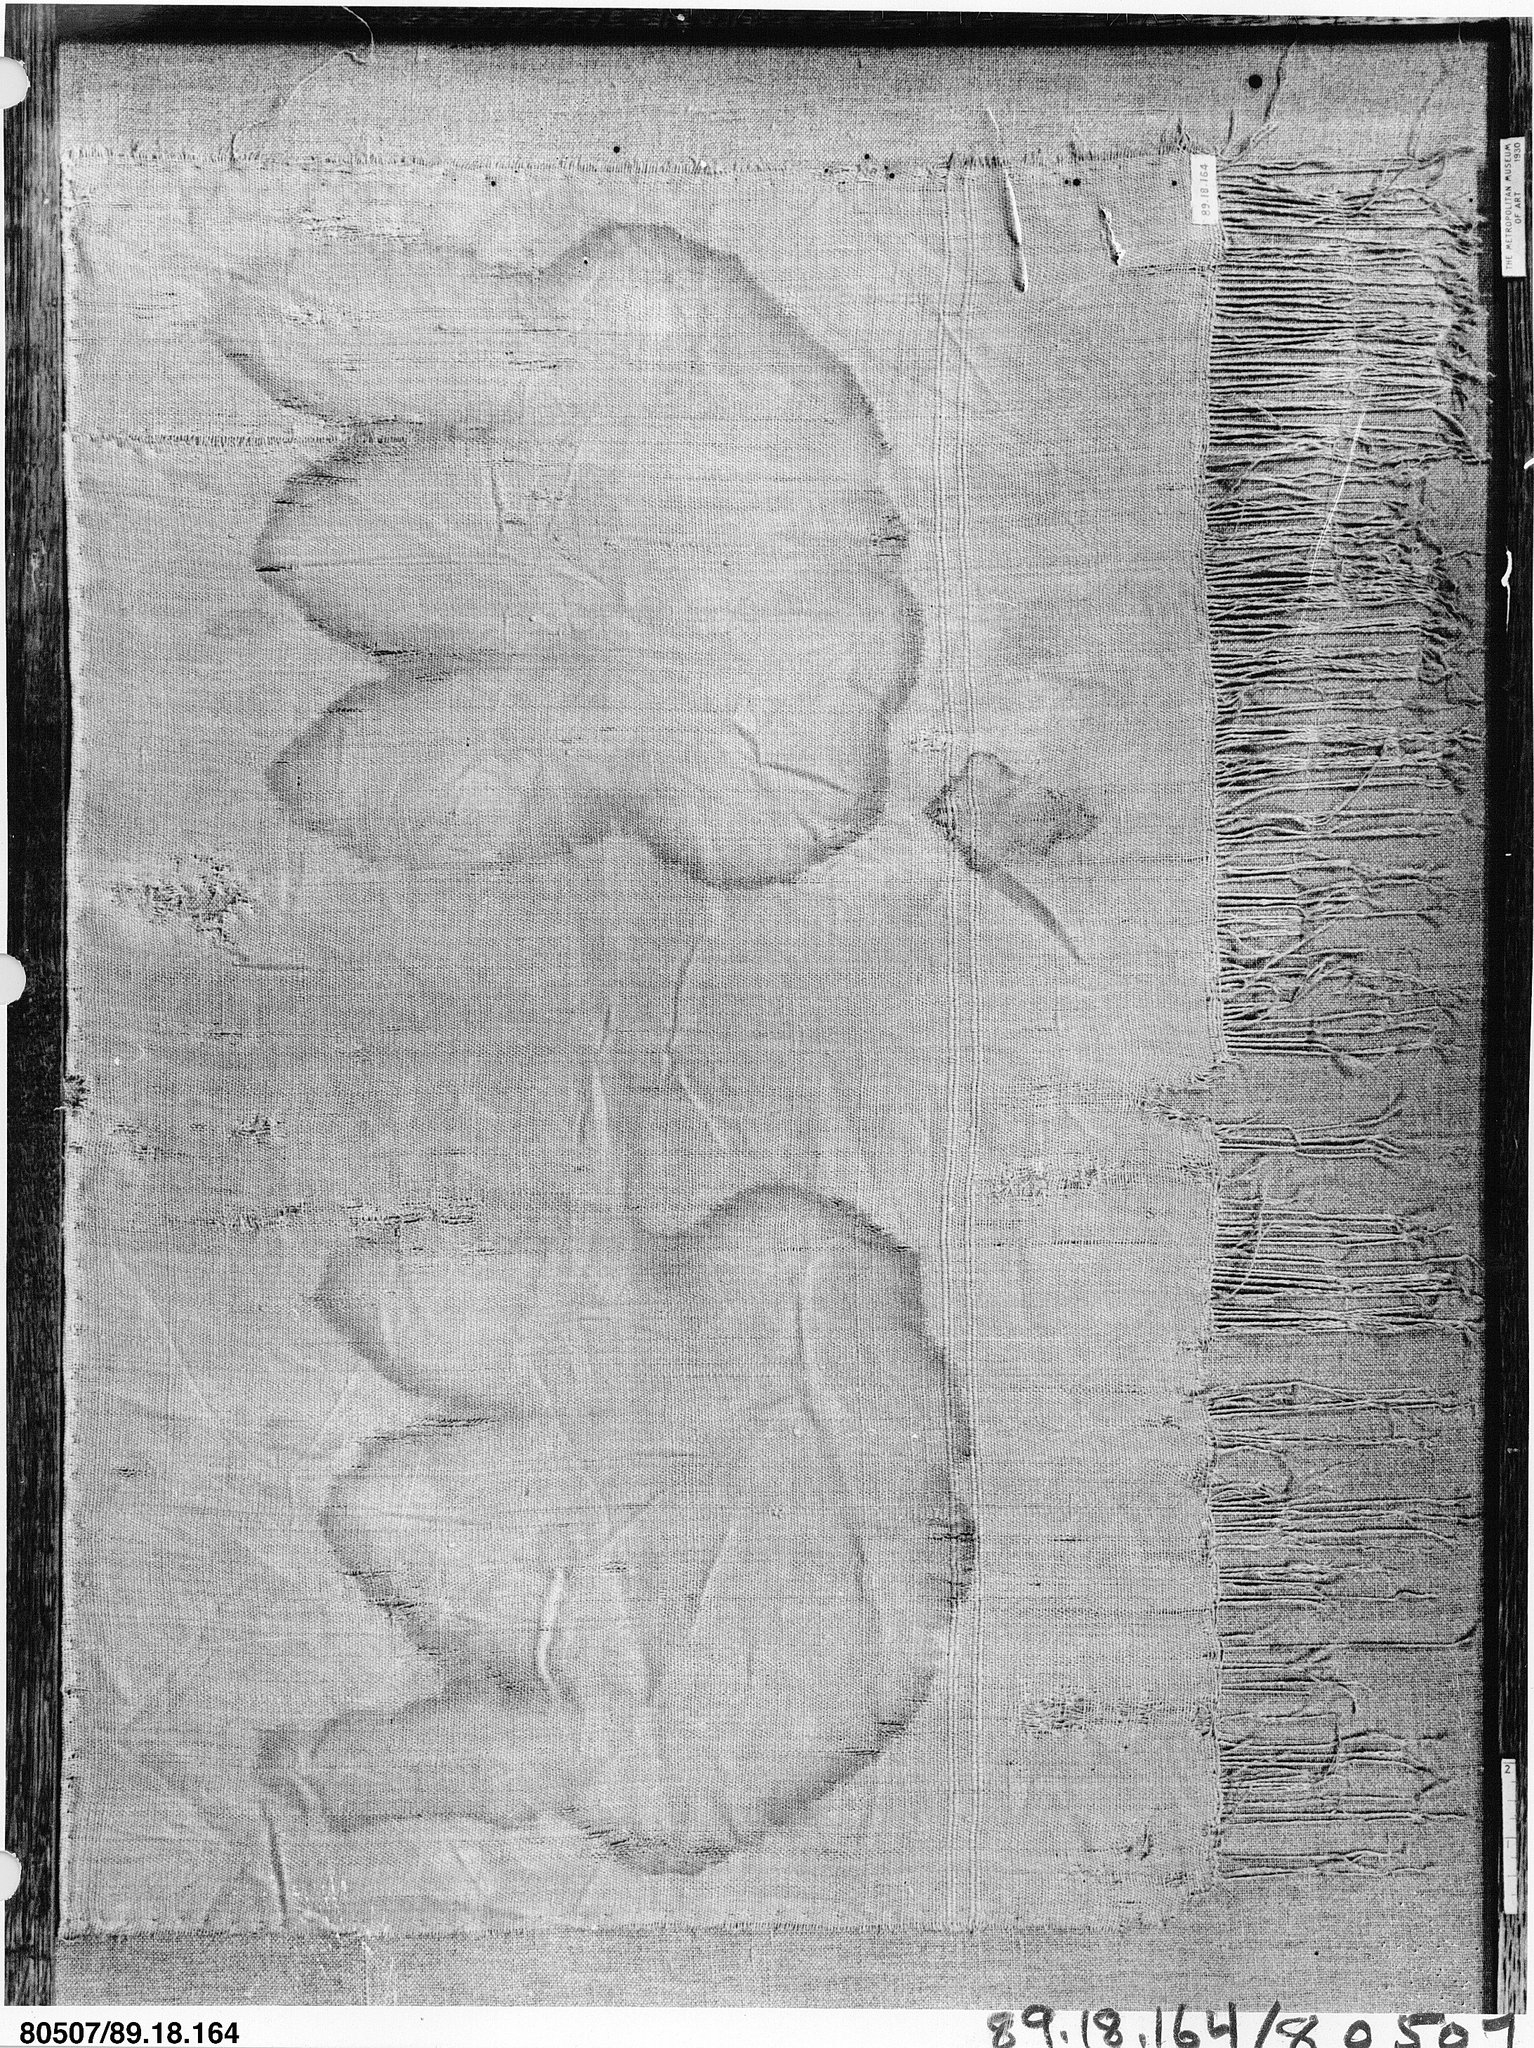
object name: textile fragment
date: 201-500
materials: wool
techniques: weave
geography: egypt